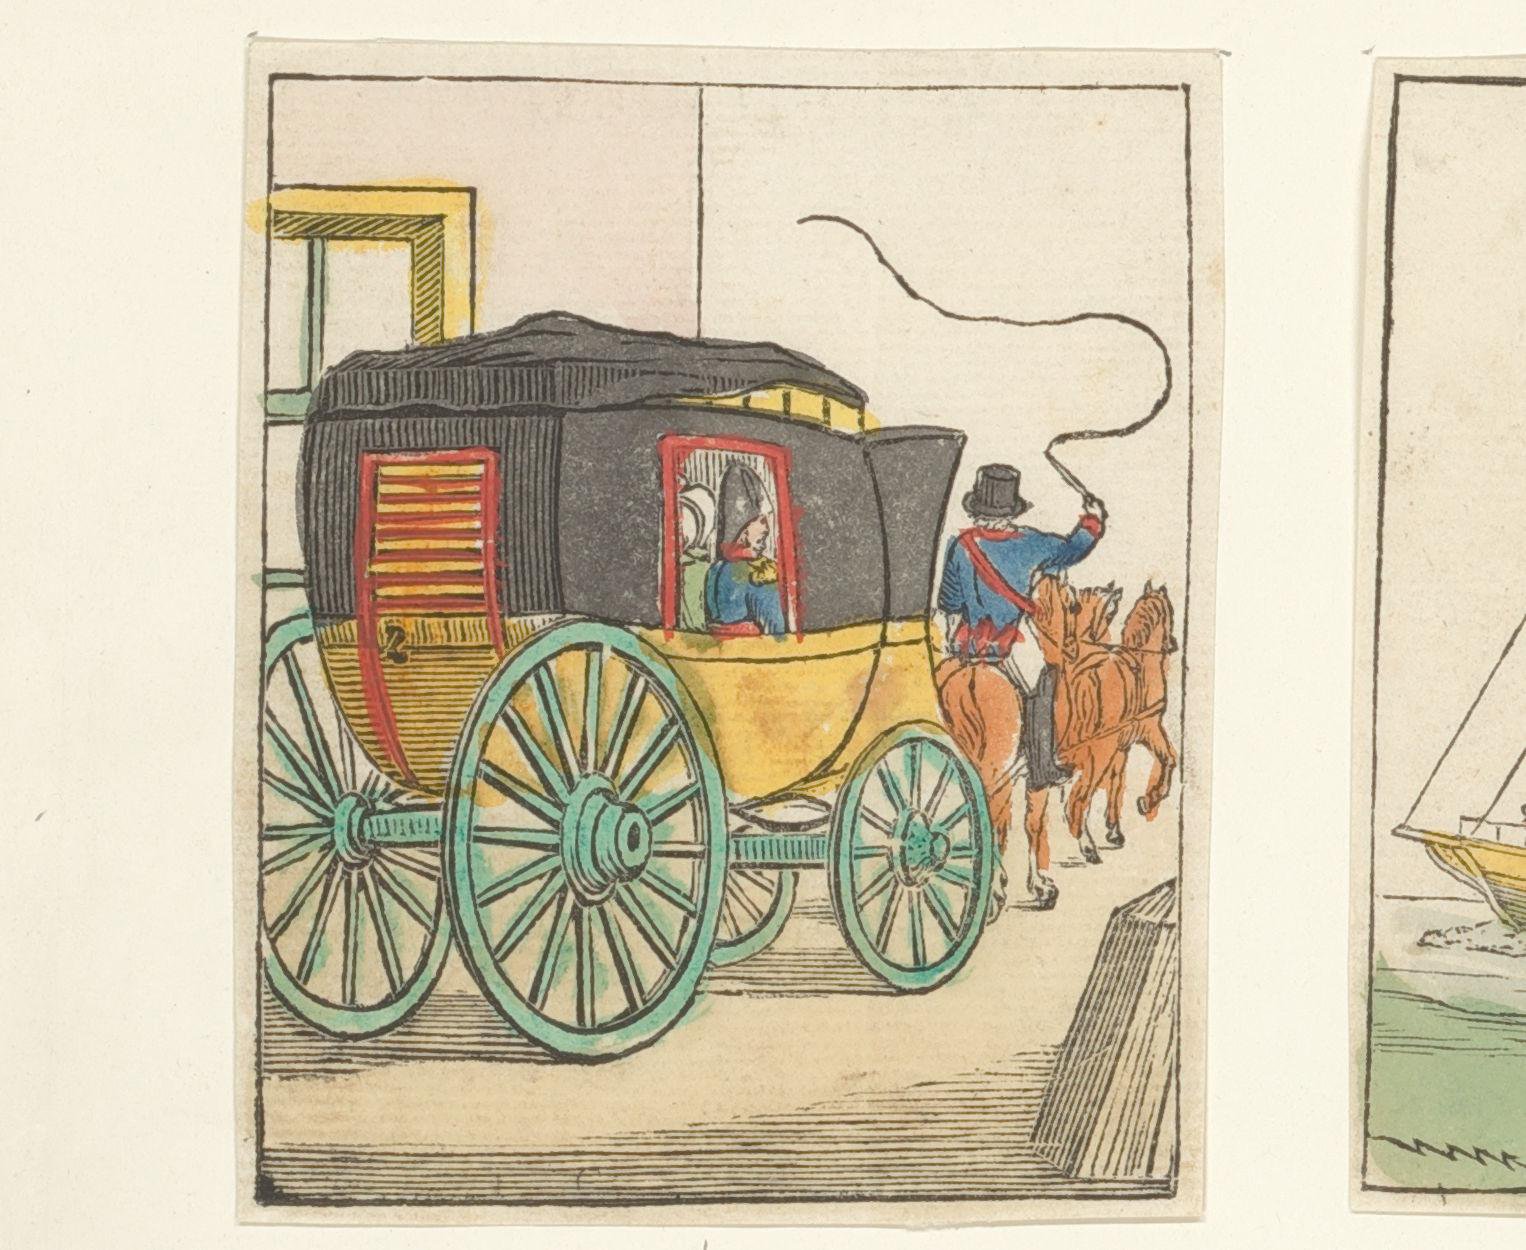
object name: print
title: Stel in een diligence getrokken door vier paarden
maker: Anonymous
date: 1810-1830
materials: paper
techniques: hand coloring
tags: diligence, omnibus, horse-tram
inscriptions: collector's mark: Lugt 1641a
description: Prent waarschijnlijk uit: Nuttige en vermakelijke prentverbeeldingen: met ophelderende gesprekken, kleine raadsels en charaden. Rotterdam: T.J. WIjnhoven Hendriksen, 1830. Of een eerdere uitgave (1827).